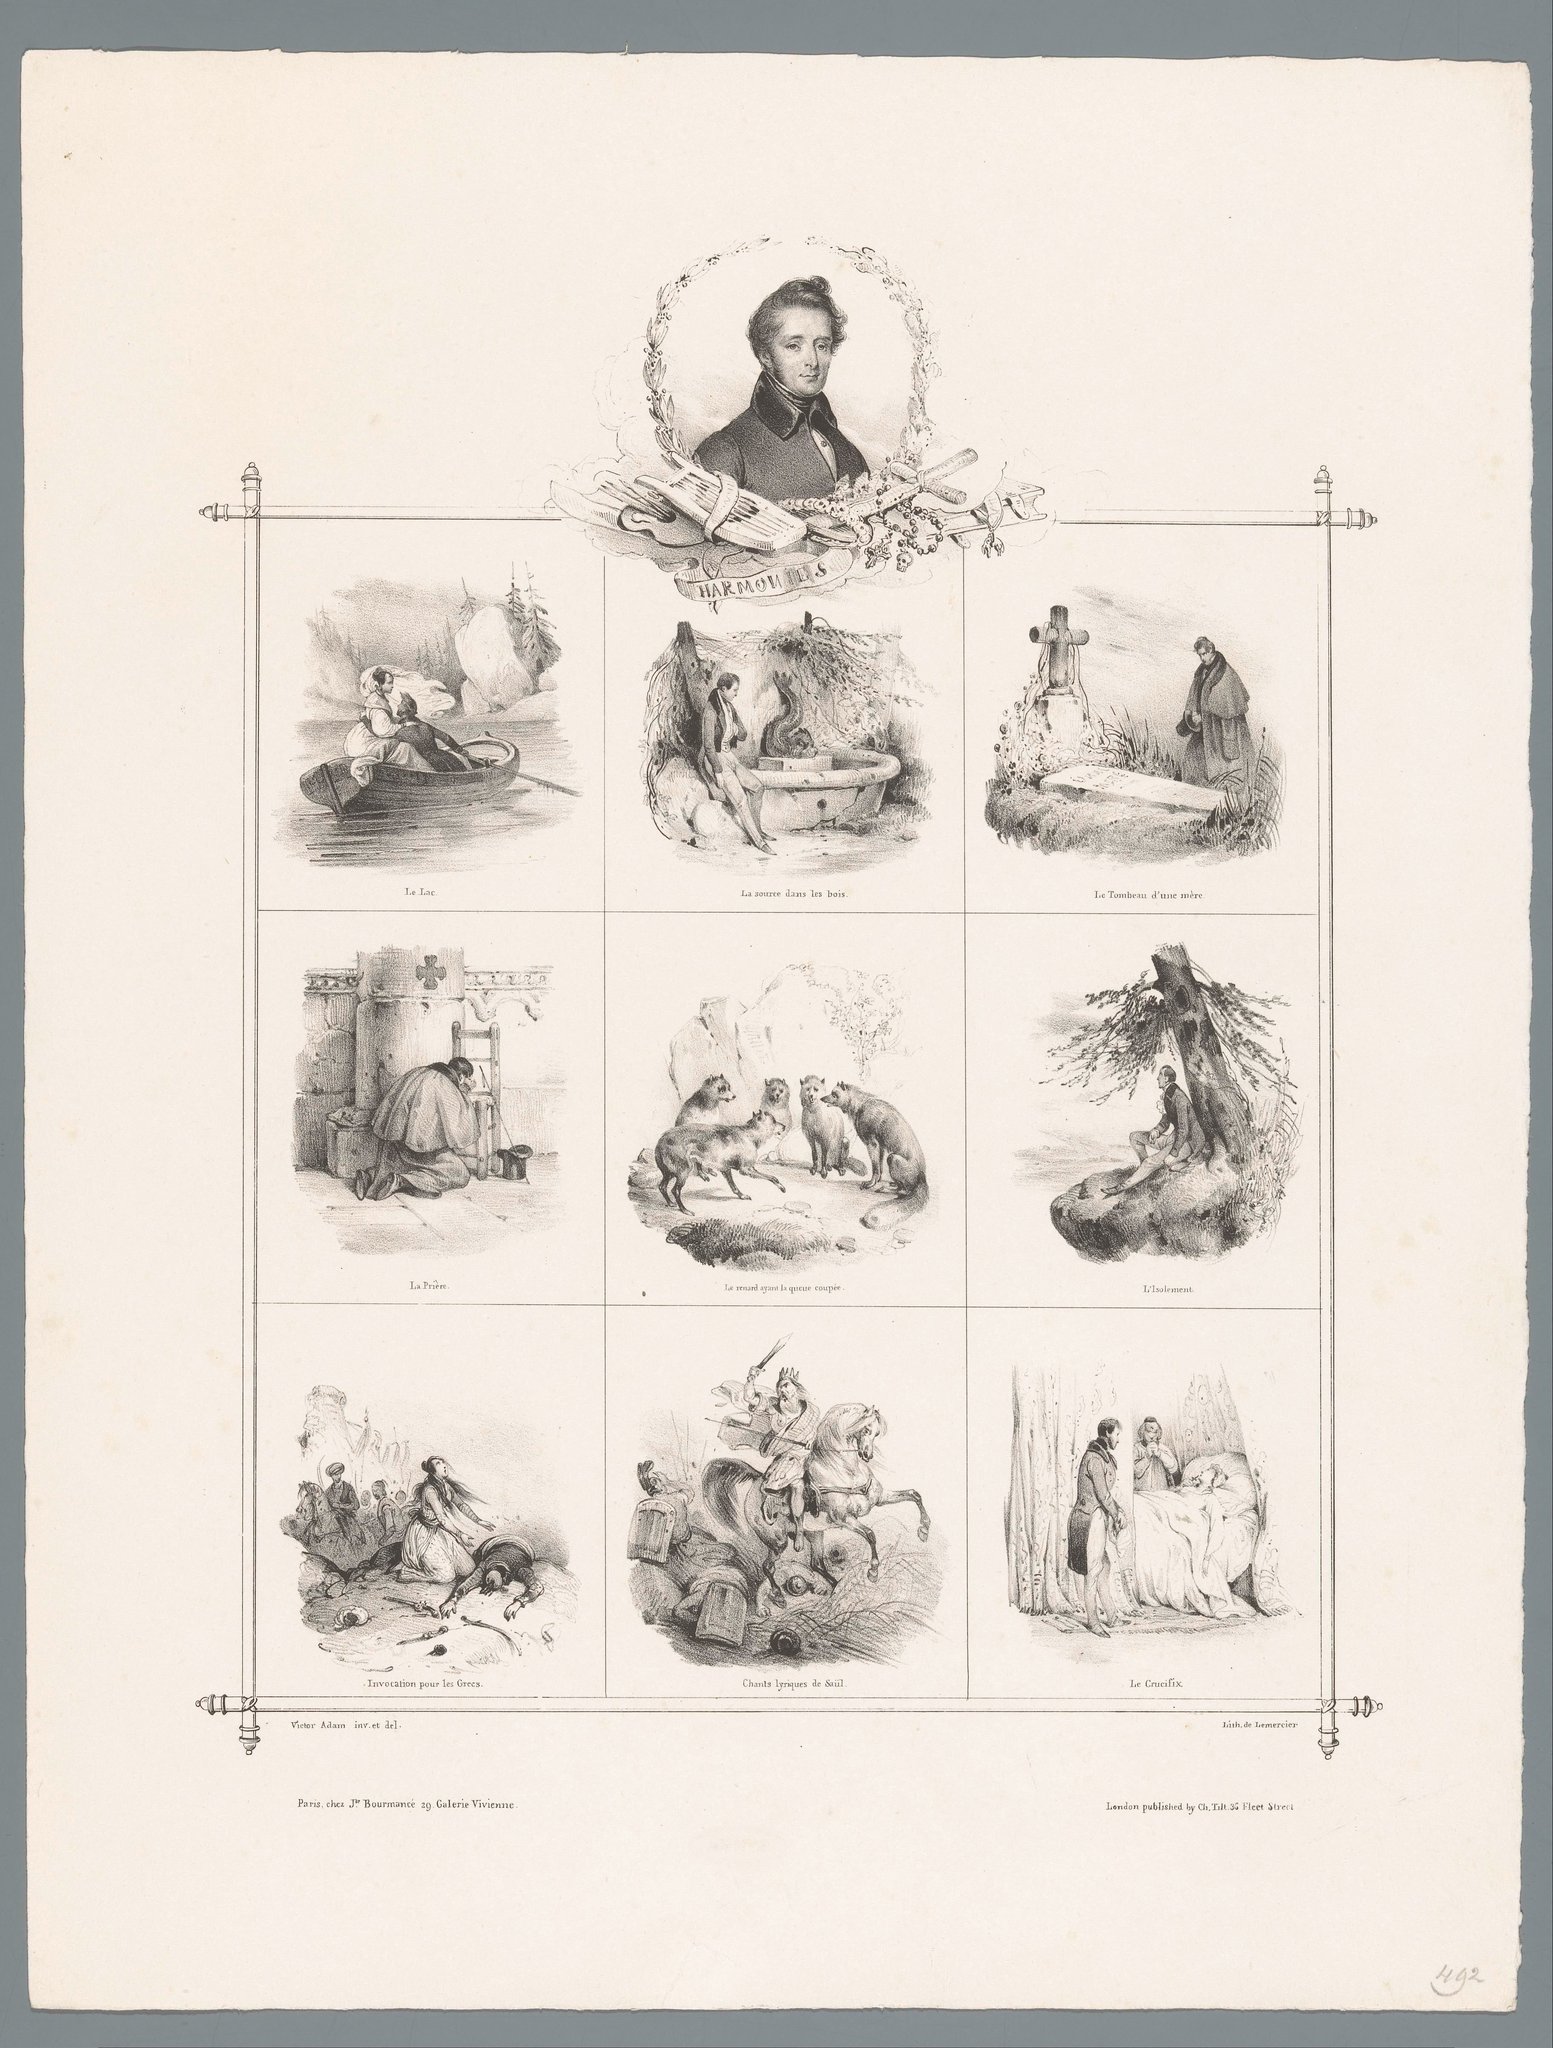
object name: print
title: Portretten van schrijvers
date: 1835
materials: paper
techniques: lithograph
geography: paris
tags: paris, historical persons, portrait of a writer, (scenes from) specific works of literature (with author, title)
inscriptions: collector's mark: Lugt 2228, number: ‘492’